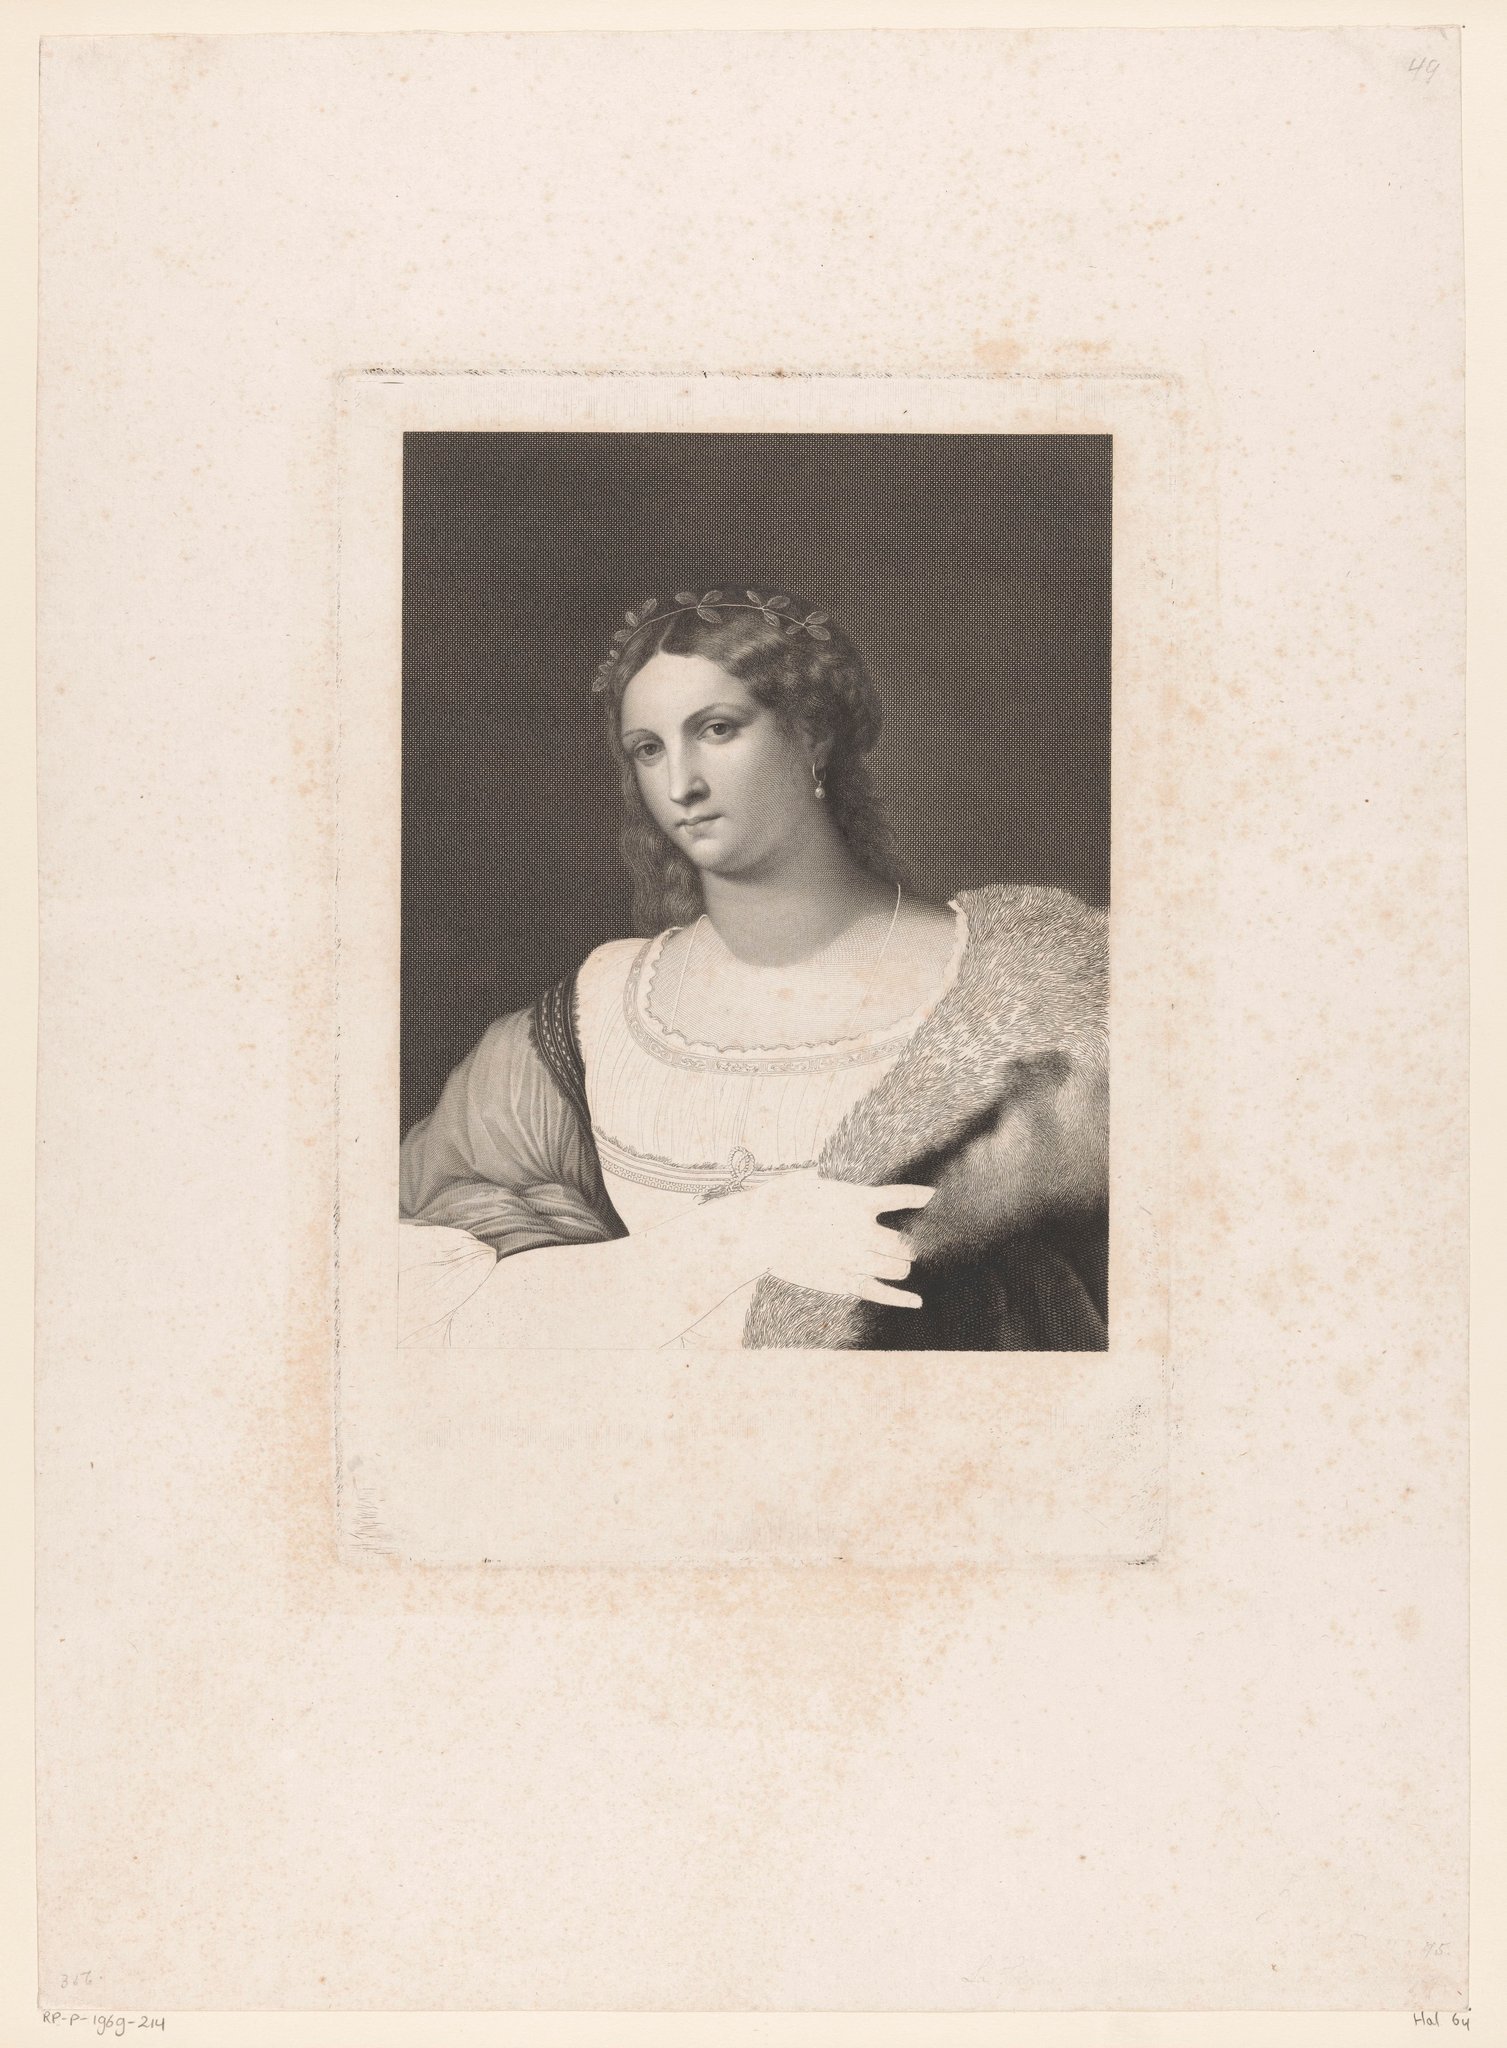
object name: print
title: Portret van een vrouw met bontmantel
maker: raphael morghen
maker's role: draughtsman, painter, print maker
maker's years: 1758-1833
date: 1768-1833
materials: paper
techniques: engraving, etching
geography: italy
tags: anonymous historical person portrayed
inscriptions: collector's mark: Lugt 2228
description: Naar een portret door Sebastiano del Piombo, dat vroeger werd toegeschreven aan Rafaël. Het schilderij bevindt zich in de Galleria degli Uffizi te Florence.